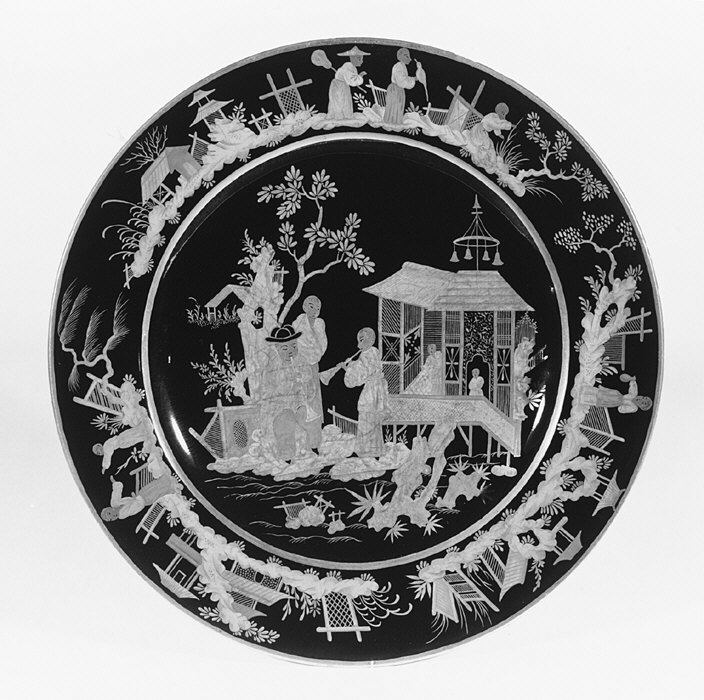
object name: plate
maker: sèvres manufactory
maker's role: manufactory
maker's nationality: french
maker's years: 1740-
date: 1791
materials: hard paste porcelain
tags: musical instruments,chinoiserie,buildings,men